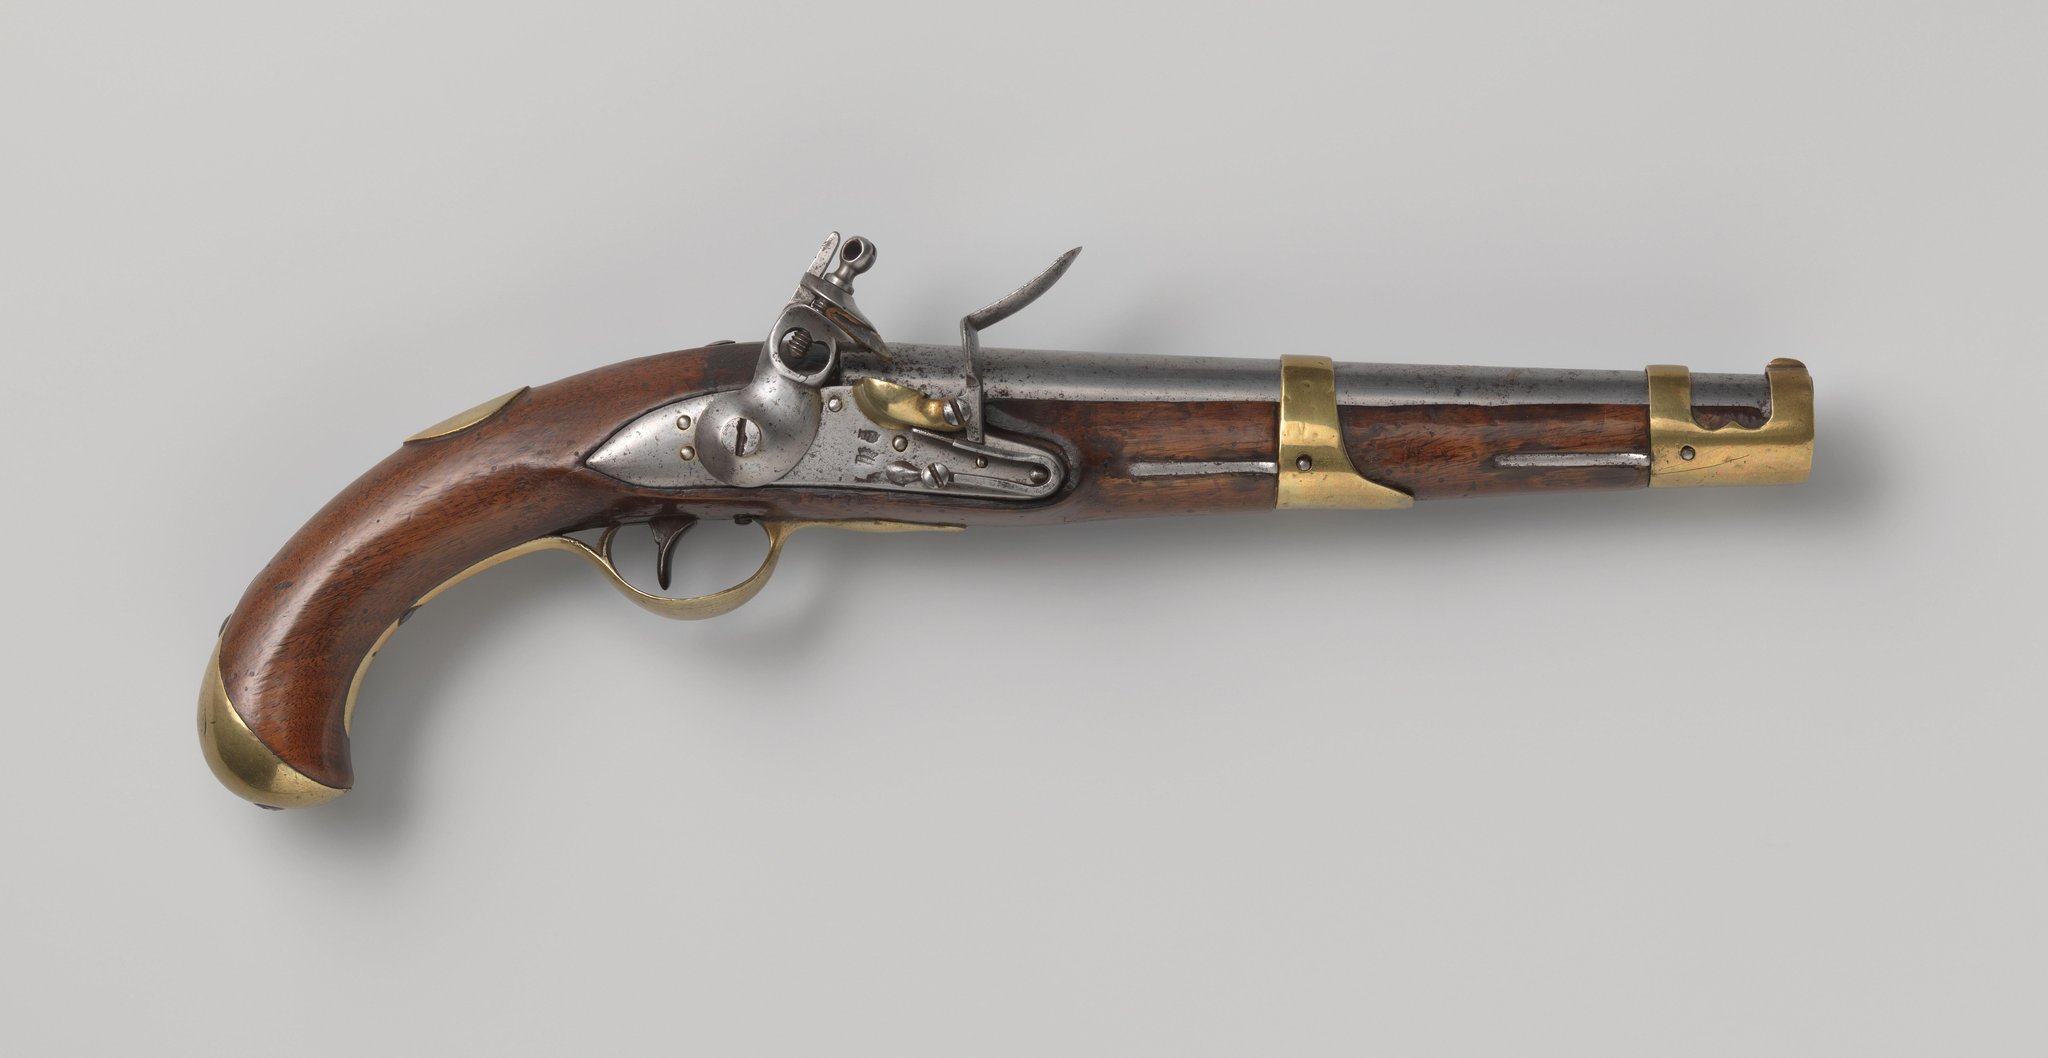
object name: flintlock pistol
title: Vuursteen cavaleriepistool Staatse leger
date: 1780-1790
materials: brass, iron, wood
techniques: printing, cutting, engraving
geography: culemborg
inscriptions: : ‘B3’, : ‘AG’, mark: ‘HI of IH’, coat of arms: ‘DM’